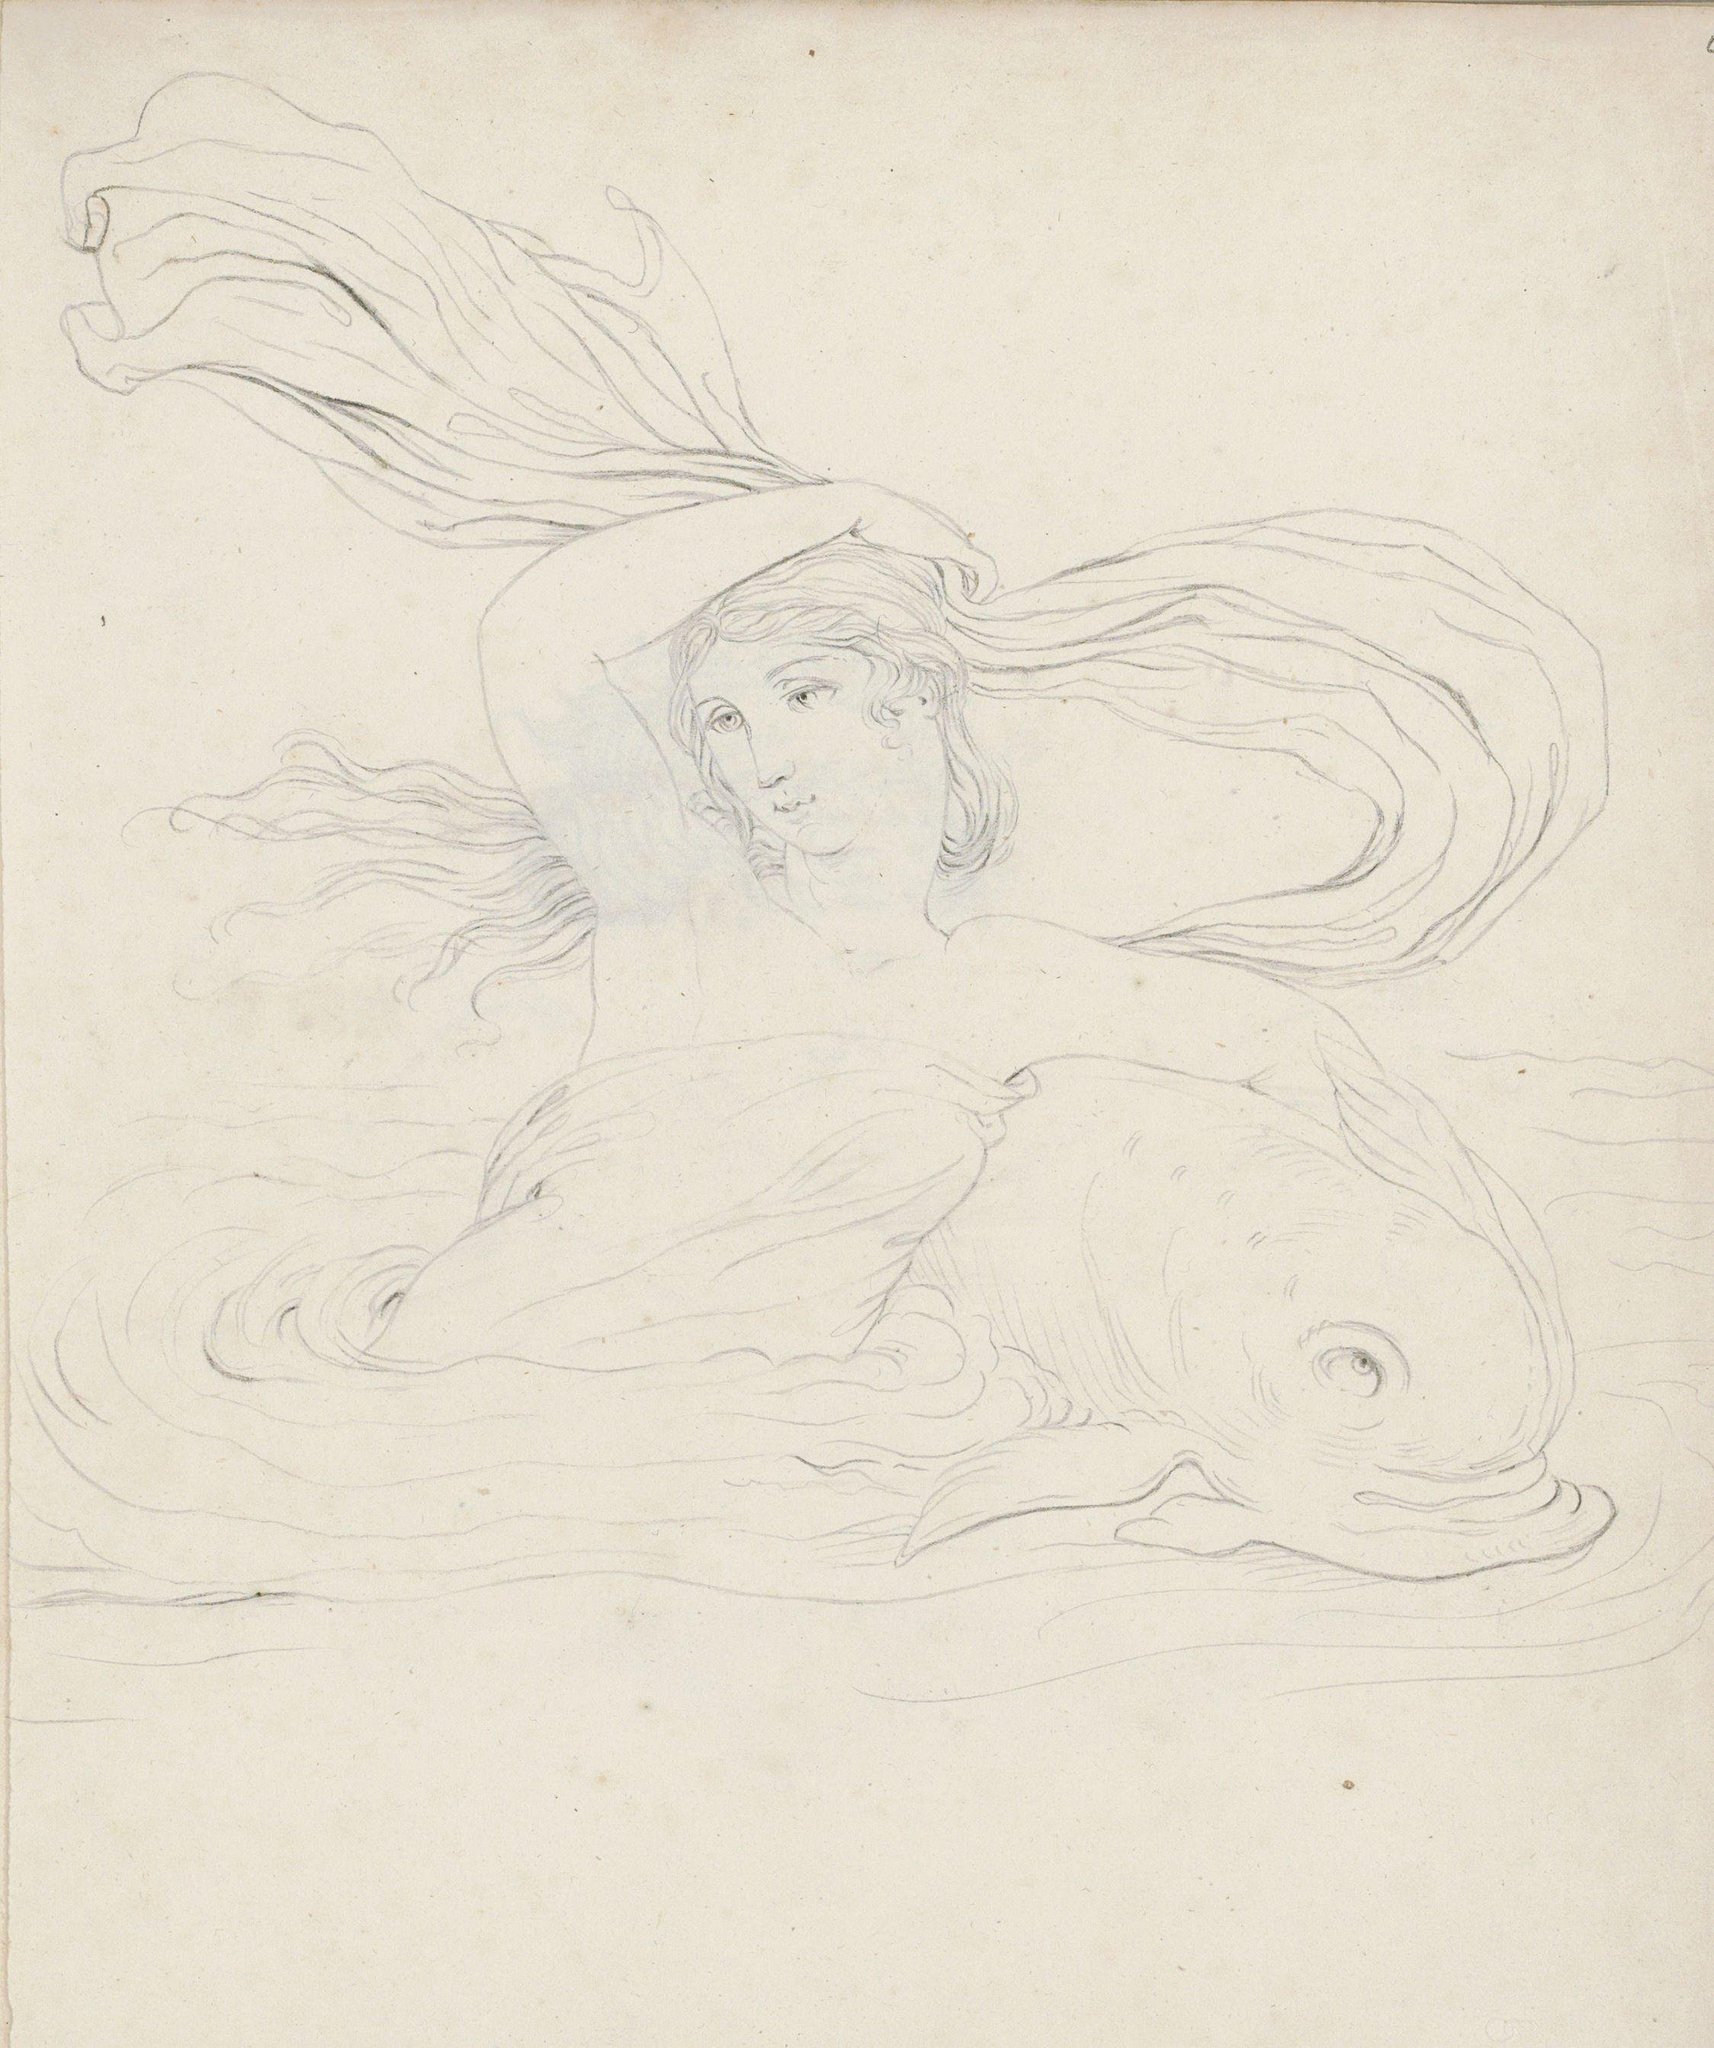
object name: sketchbook leaf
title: Nereïde, vermoedelijk Galatea, met haar arm over een zeewezen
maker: jonkvrouw elisabeth kemper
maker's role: draughtsman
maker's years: 1799-1871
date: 1815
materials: paper, pencil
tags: sitting figure - aa - female human figure, the sorrowing penelope, classical mythology and ancient history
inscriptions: date: ‘1815’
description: De zeenimf staat tot aan haar middel in het water. Boven haar hoofd een draperie. Vermoedelijk getekend naar klassiek voorbeeld. Blad 41 recto (los) uit een schetsboek met 94 bladen.